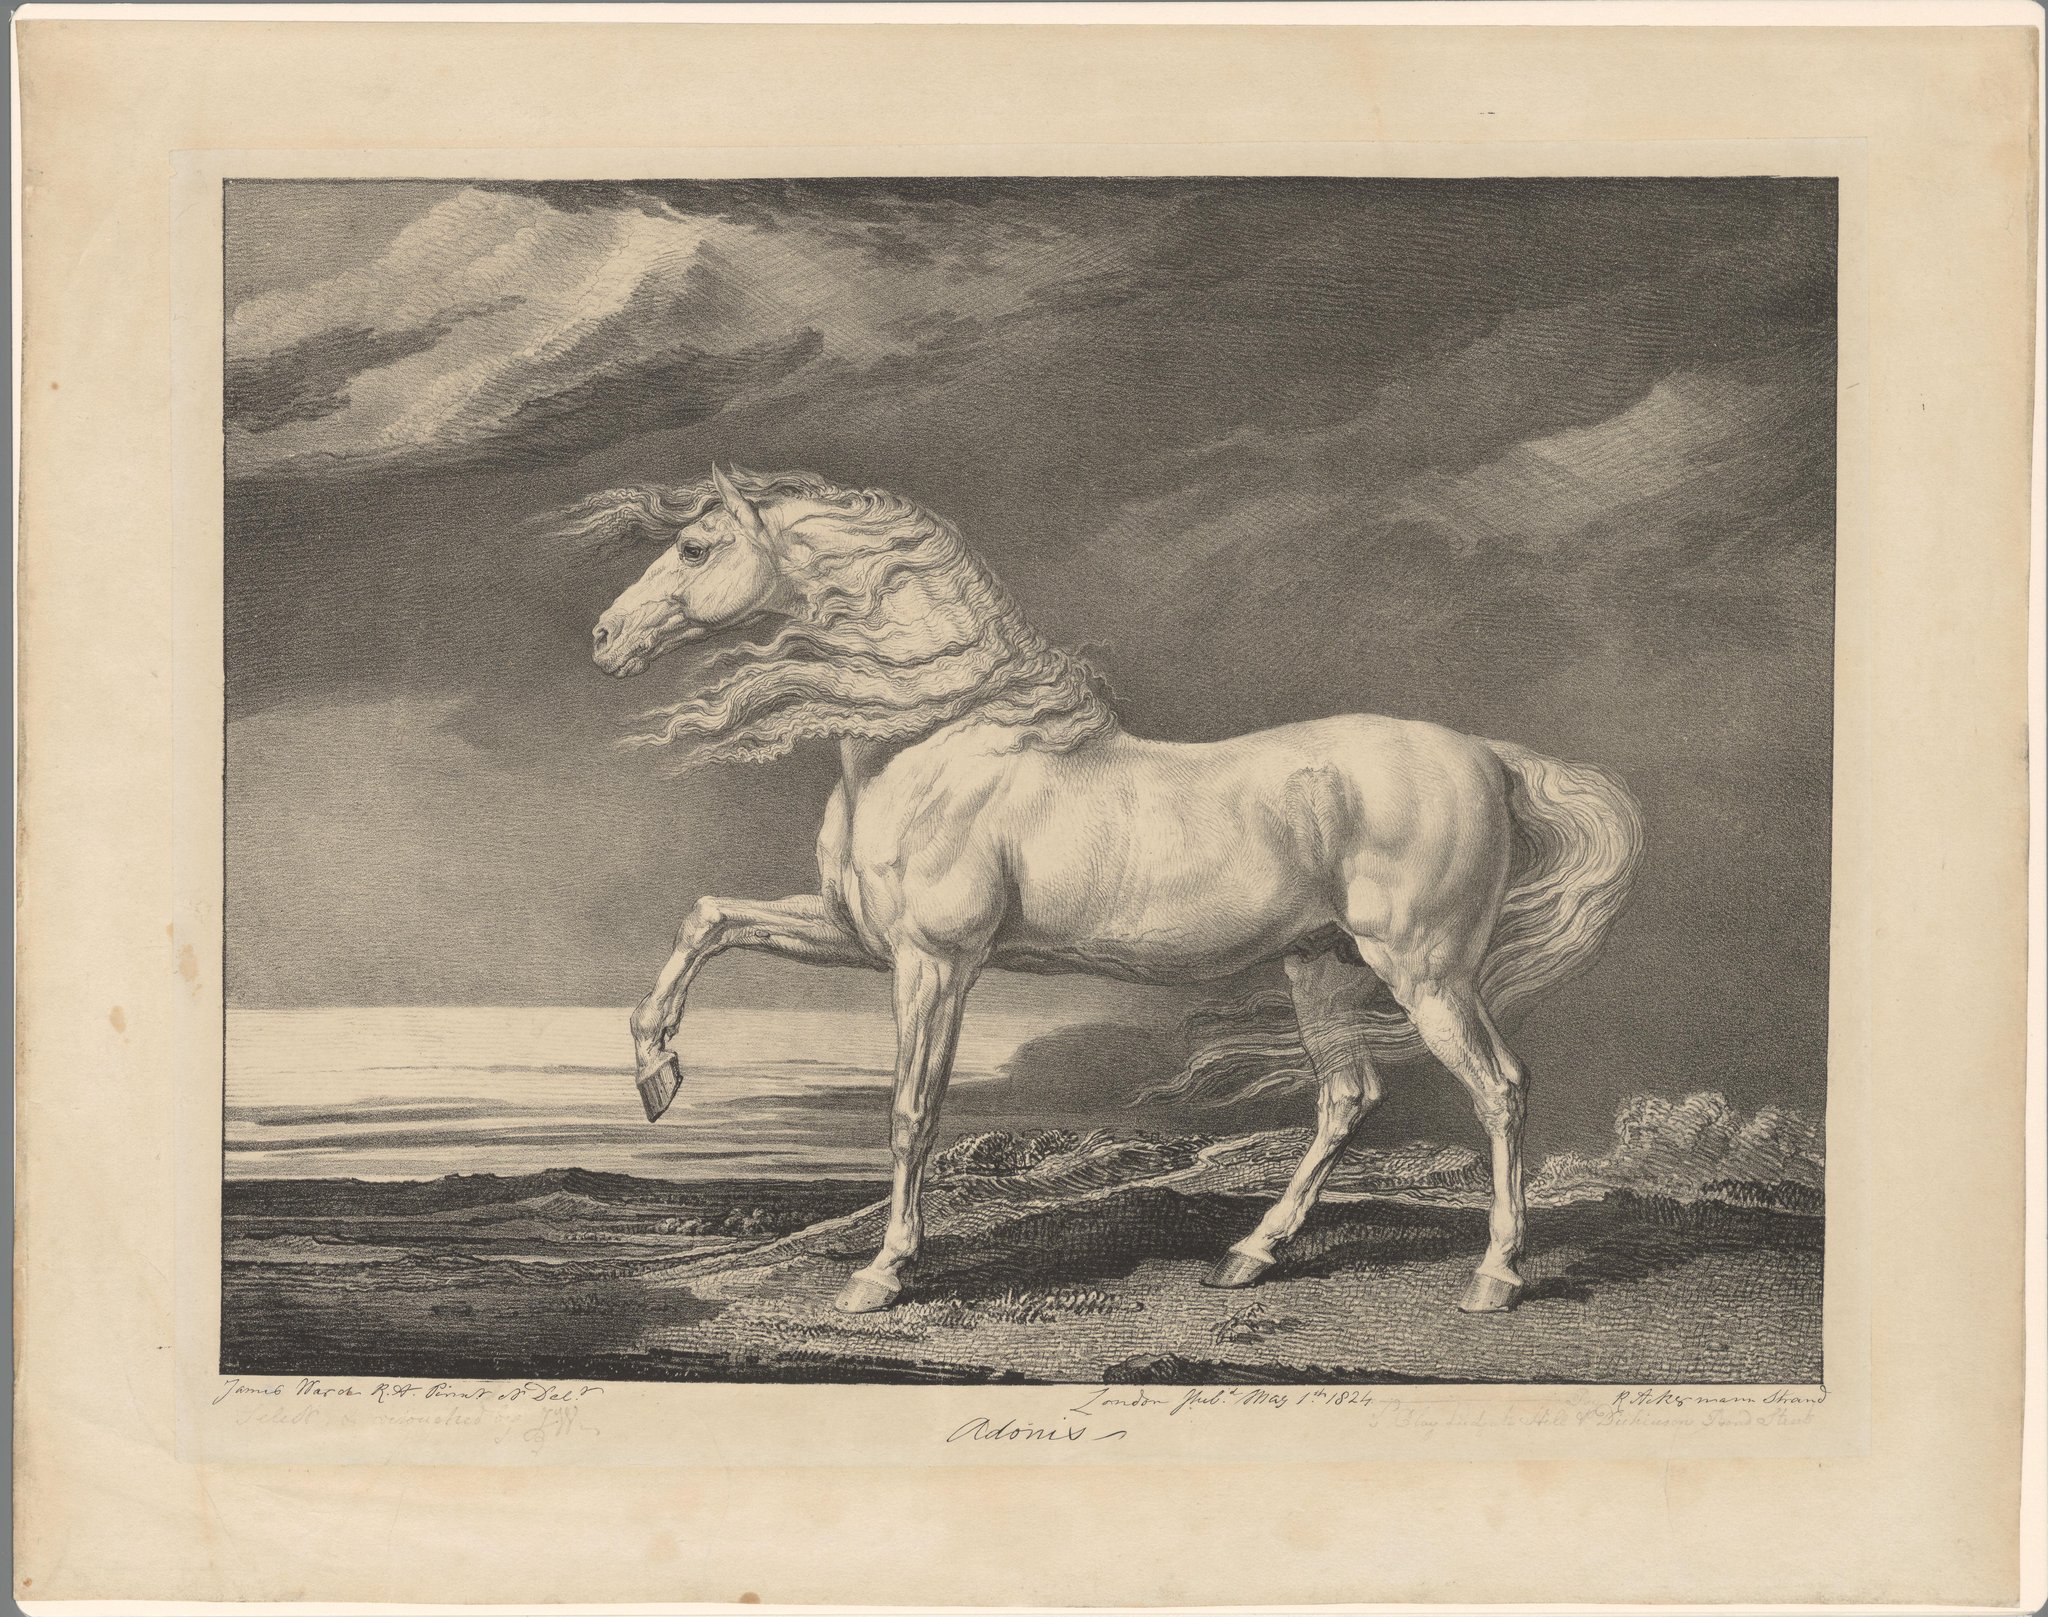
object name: print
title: Celebrated horses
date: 1824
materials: paper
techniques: lithograph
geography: london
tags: horse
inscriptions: collector's mark: Lugt 2760, collector's mark: Lugt 2228